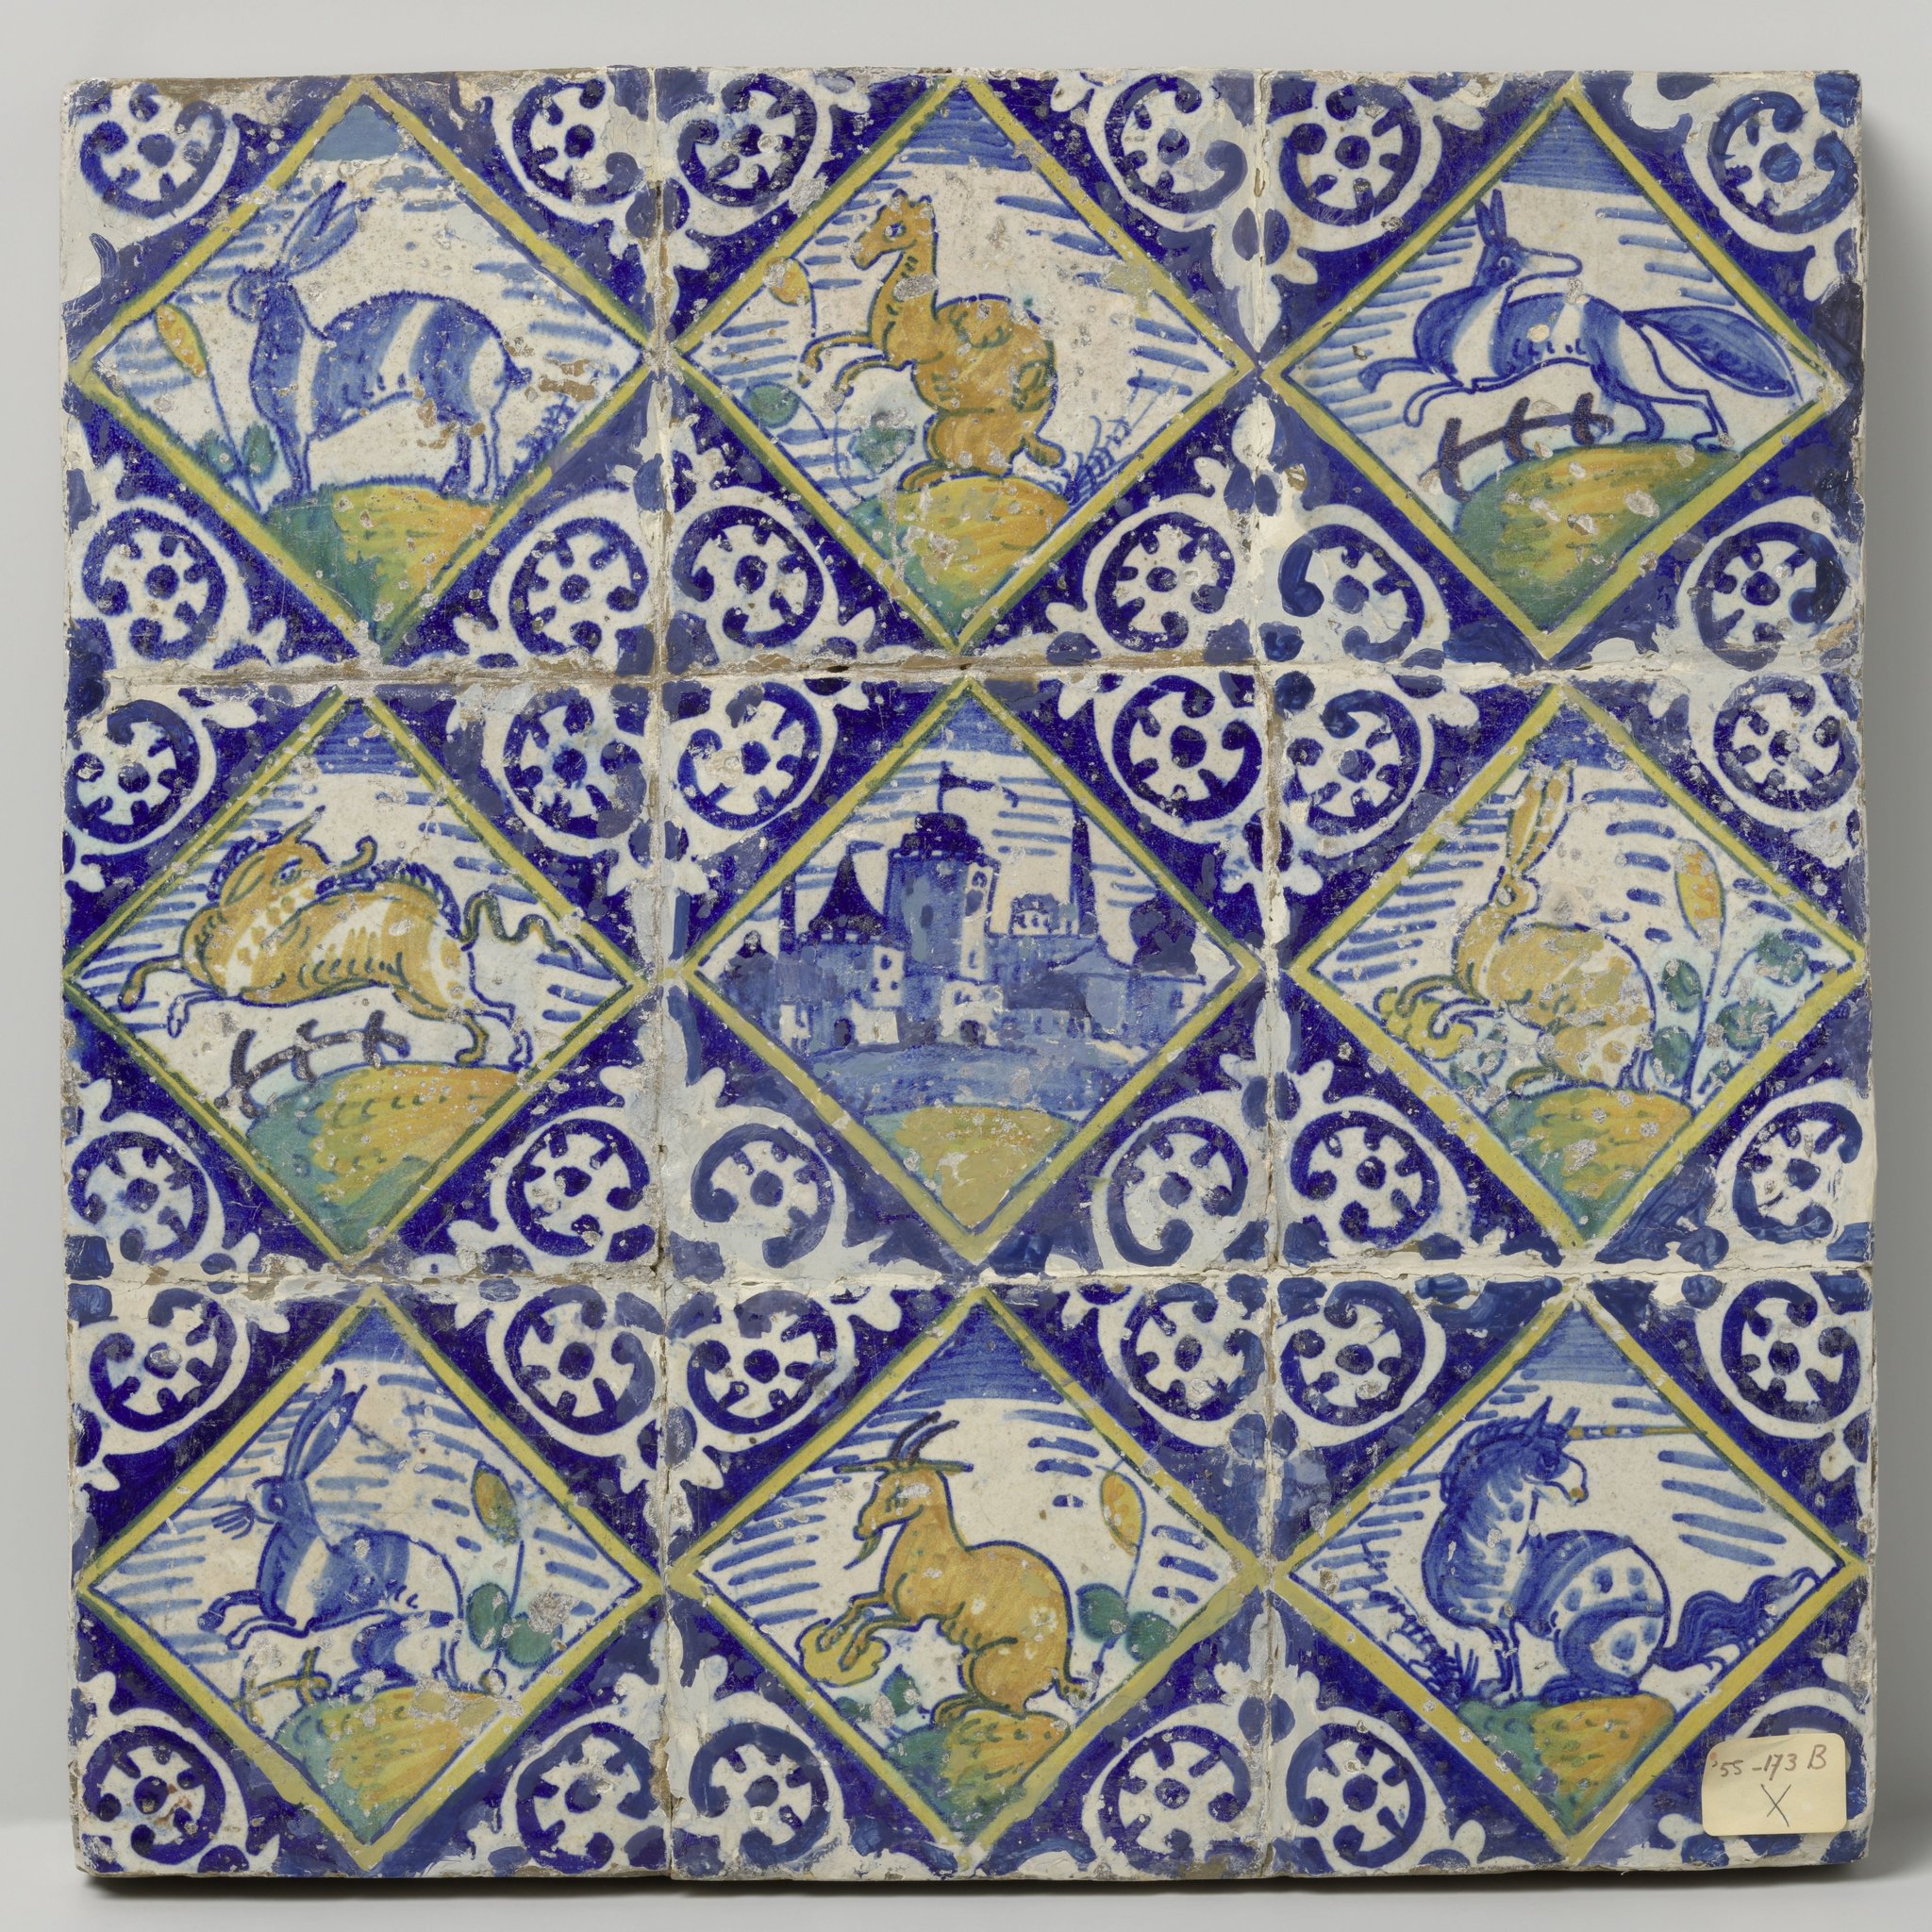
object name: tile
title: Veld van negen tegels met dieren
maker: Anonymous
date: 1580-1625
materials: earthenware, glaze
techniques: maiolica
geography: netherlands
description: Veld van negen tegels (3 x 3) elk met een veelkleurig (blauw, oranje, geel, groen en paars) geschilderd dier op een grond (waarvan één tegel met een kasteel) binnen een kwadraat. In de hoeken, ornament in vultechniek.